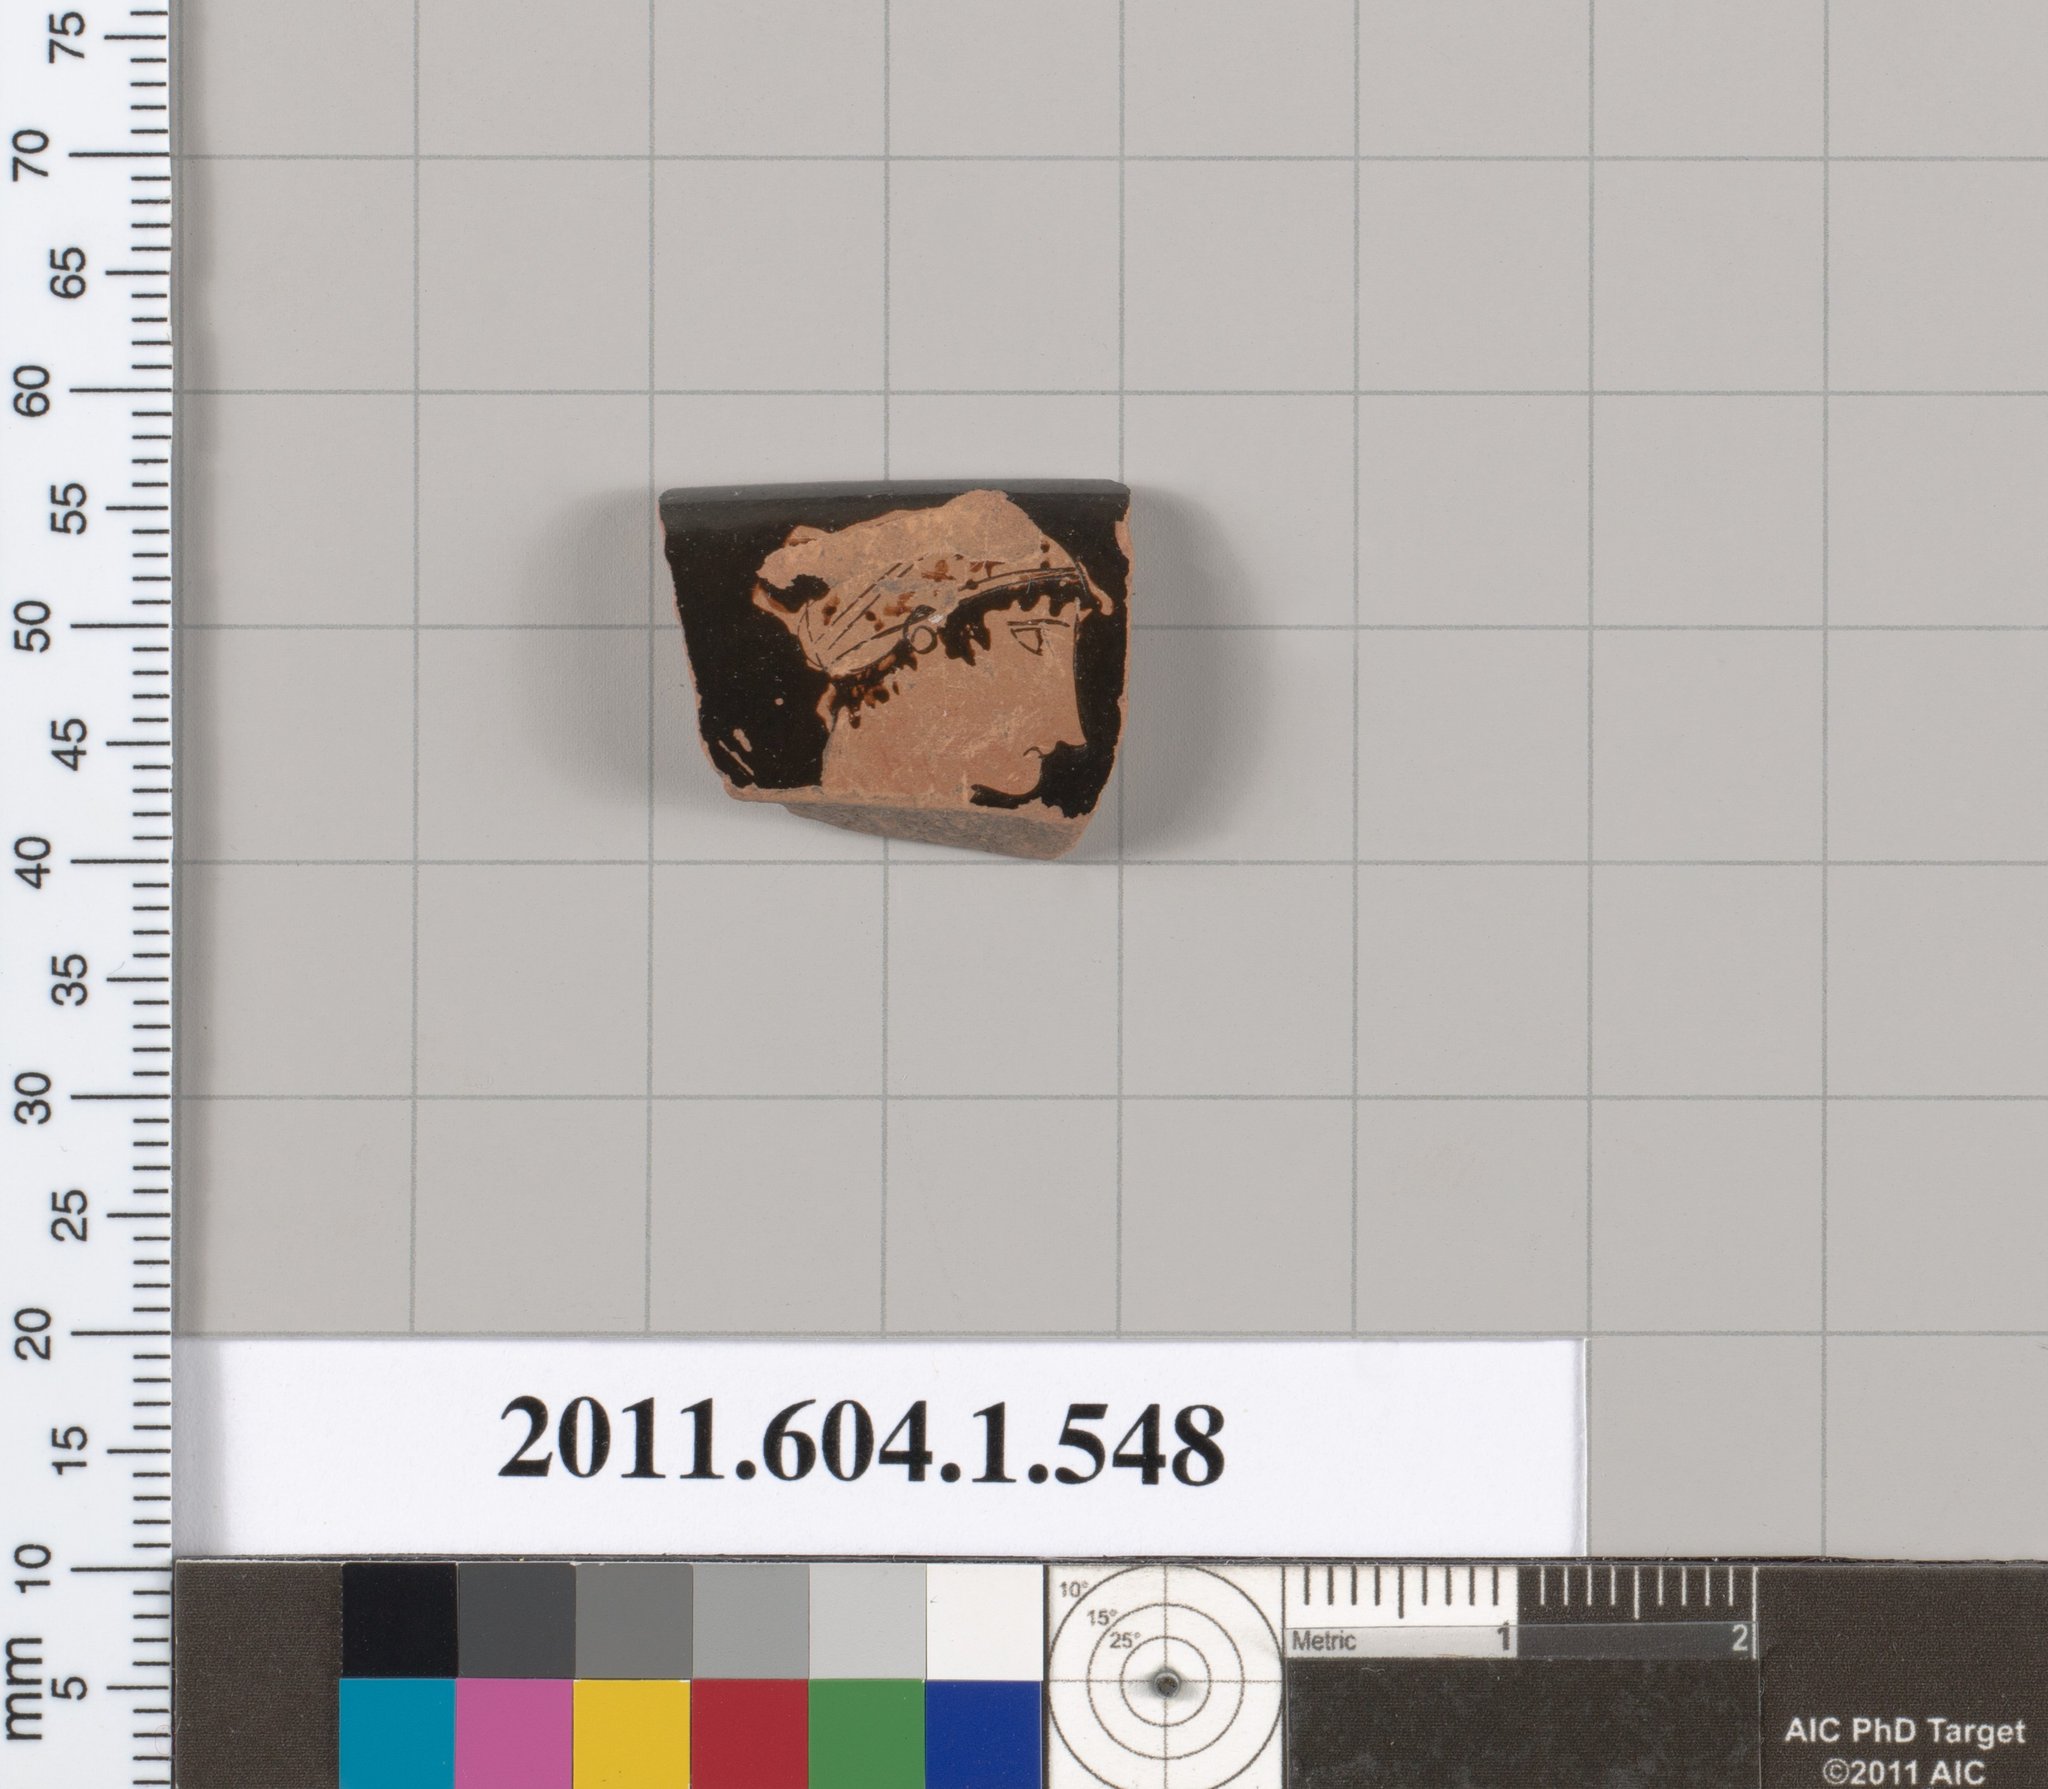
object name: kylix fragment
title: Terracotta rim fragment of a kylix (drinking cup)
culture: greek, attic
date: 475-451 BCE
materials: terracotta